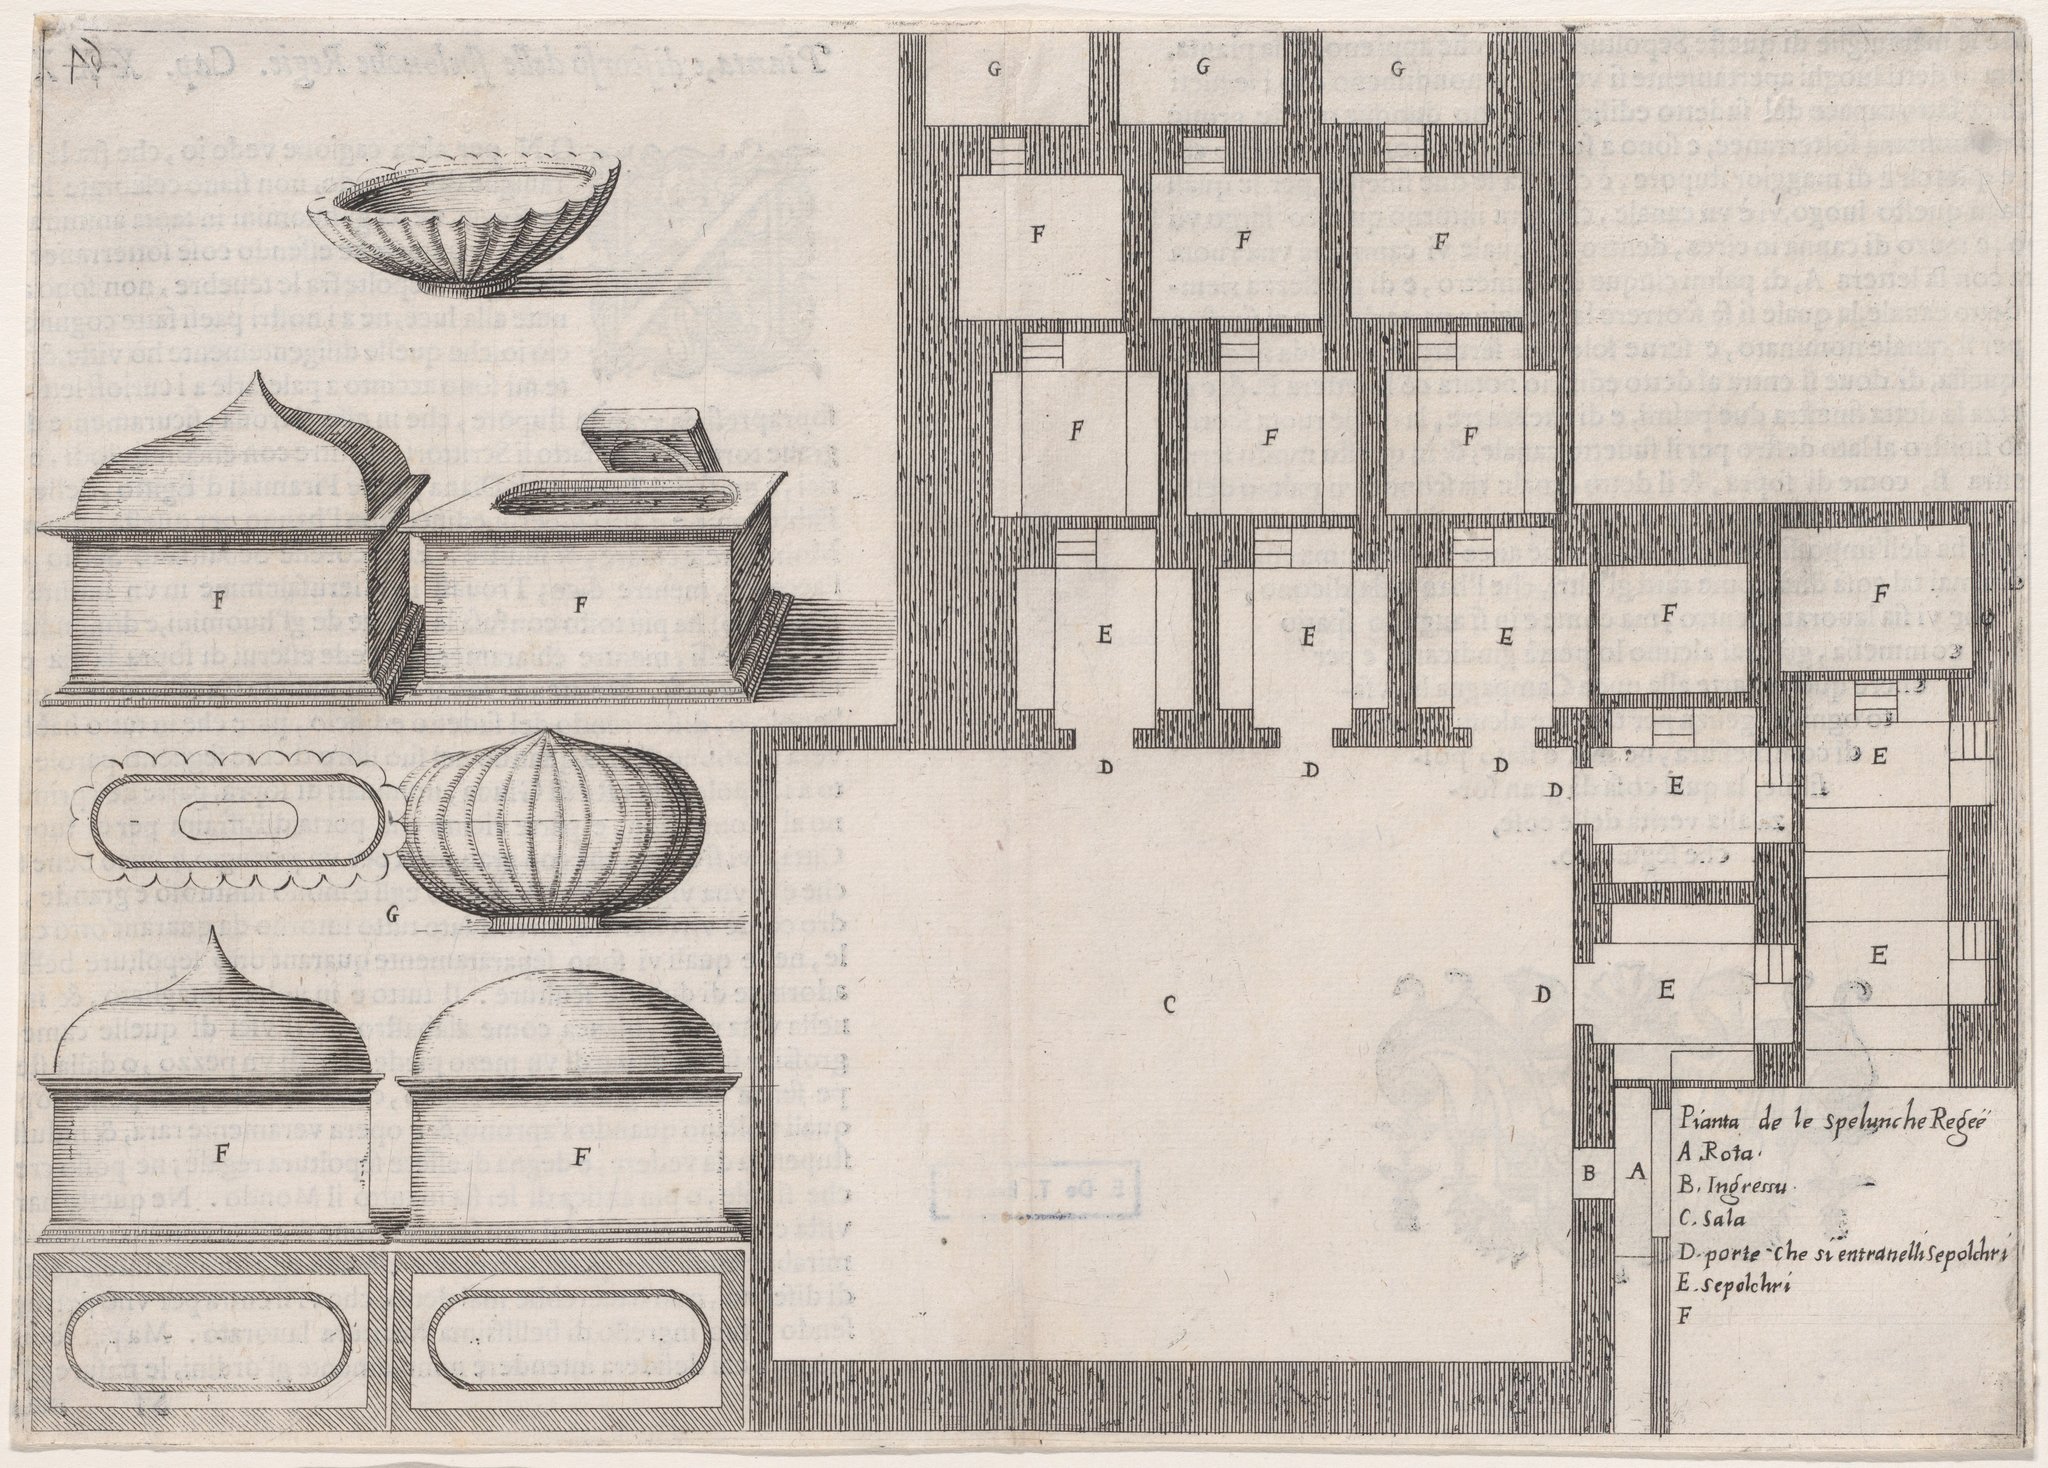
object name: print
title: Plate 38, from "Trattato delle Piante & Immagini de Sacri Edifizi di Terra Santa" (Treatise of the Plans & Images of the Sacred Buildings of the Holy Land)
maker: jacques callot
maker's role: artist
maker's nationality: french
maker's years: 1592-1635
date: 1620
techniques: engraving, etching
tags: architecture,buildings